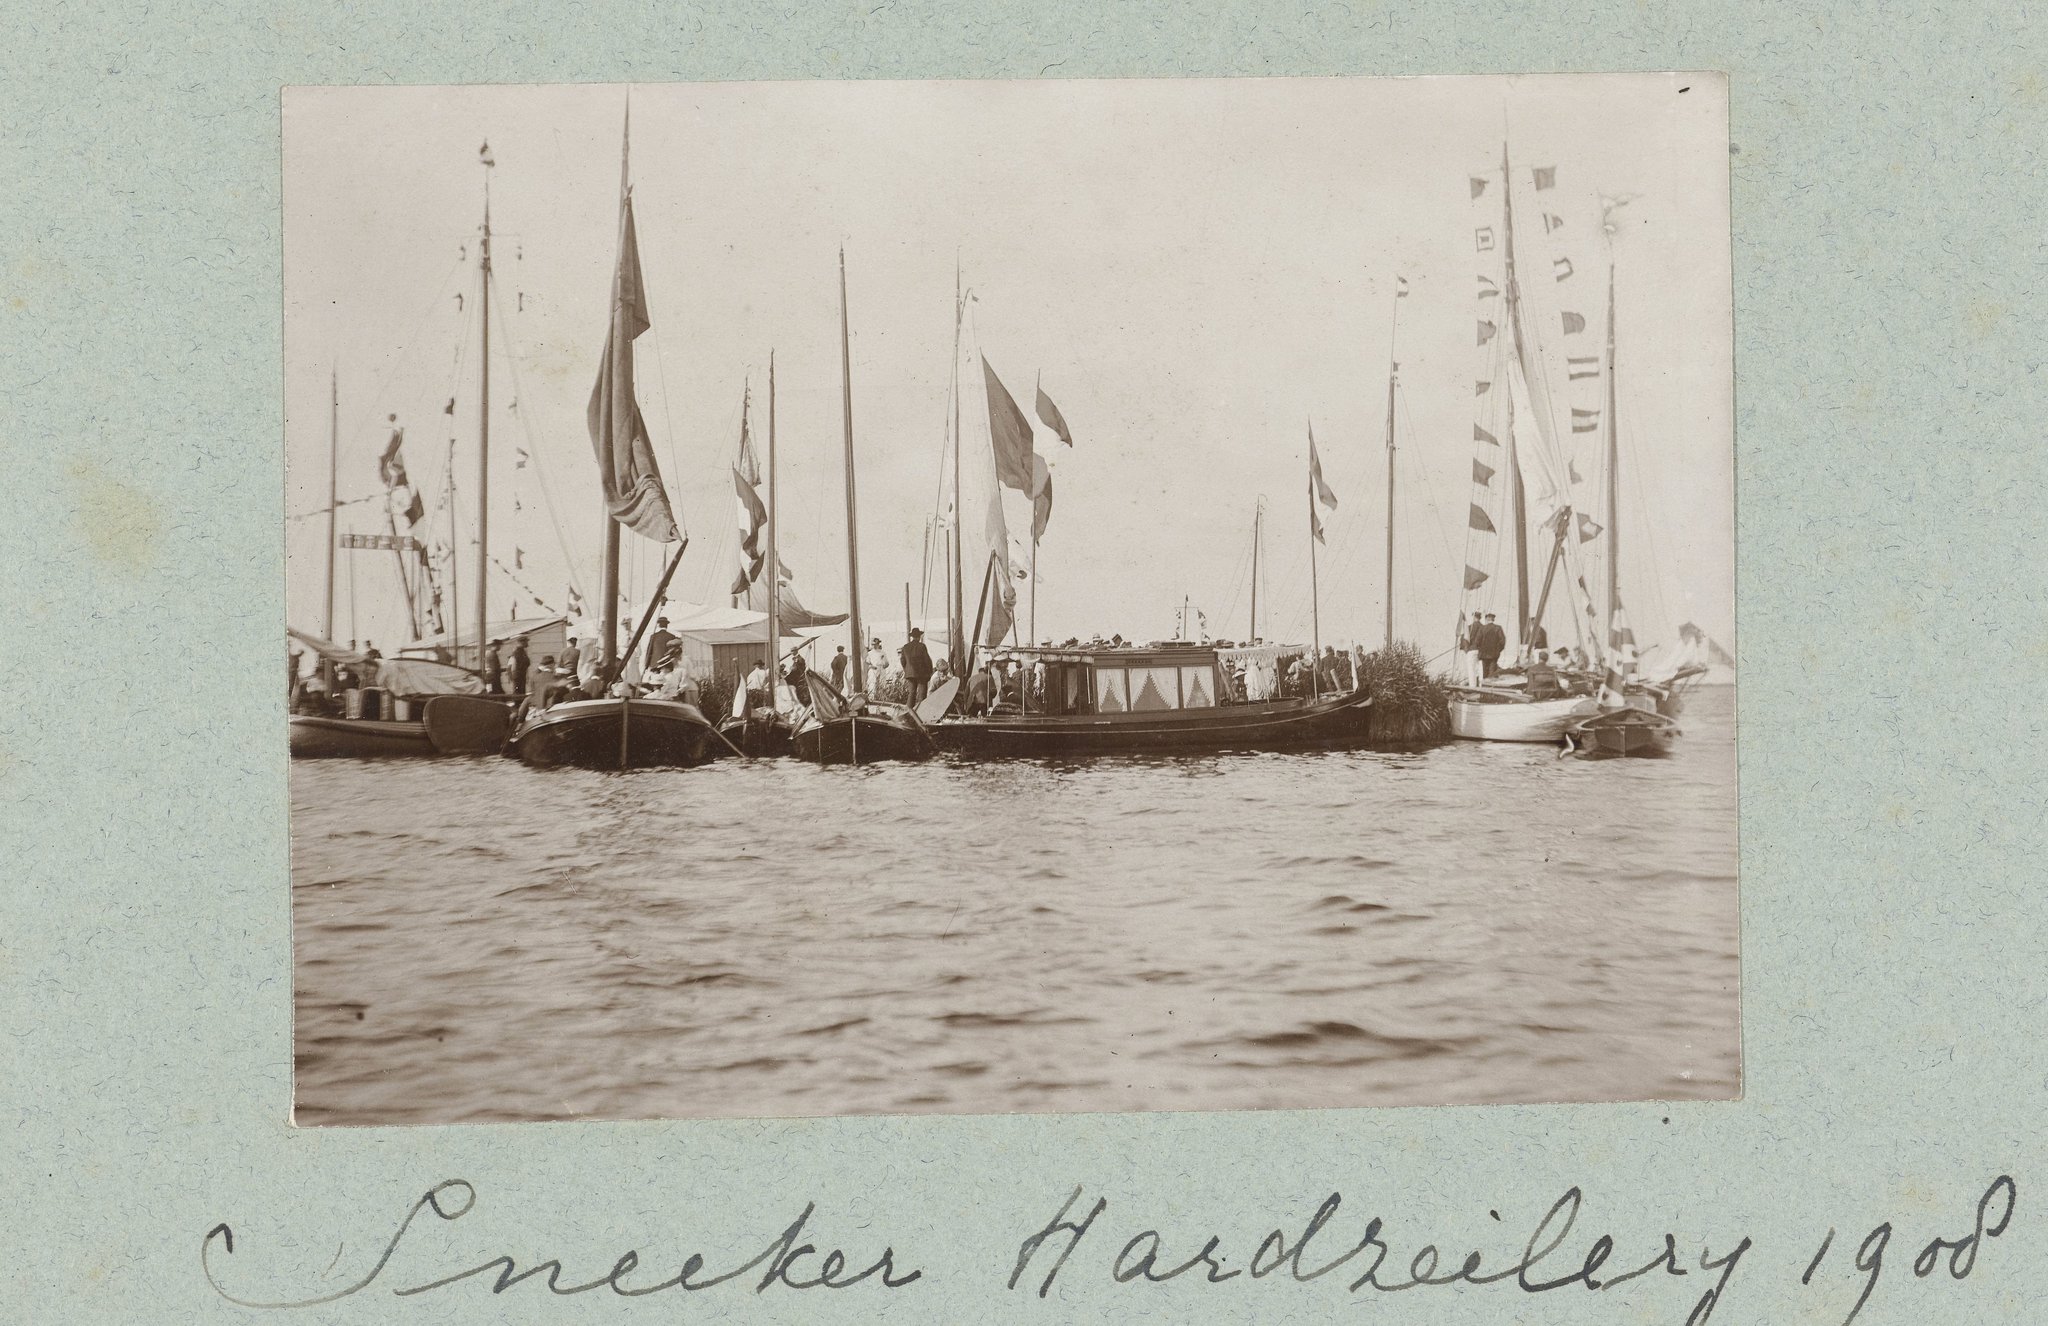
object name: photograph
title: Hollandse zeilschepen versierd met vlaggetjes liggen in het water.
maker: frits freerks fontein fz.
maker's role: fotograaf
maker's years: 1882-1928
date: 1903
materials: cardboard, paper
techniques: gelatin silver print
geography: germany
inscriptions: caption: ‘Sneeker Hardzeildag 1908’